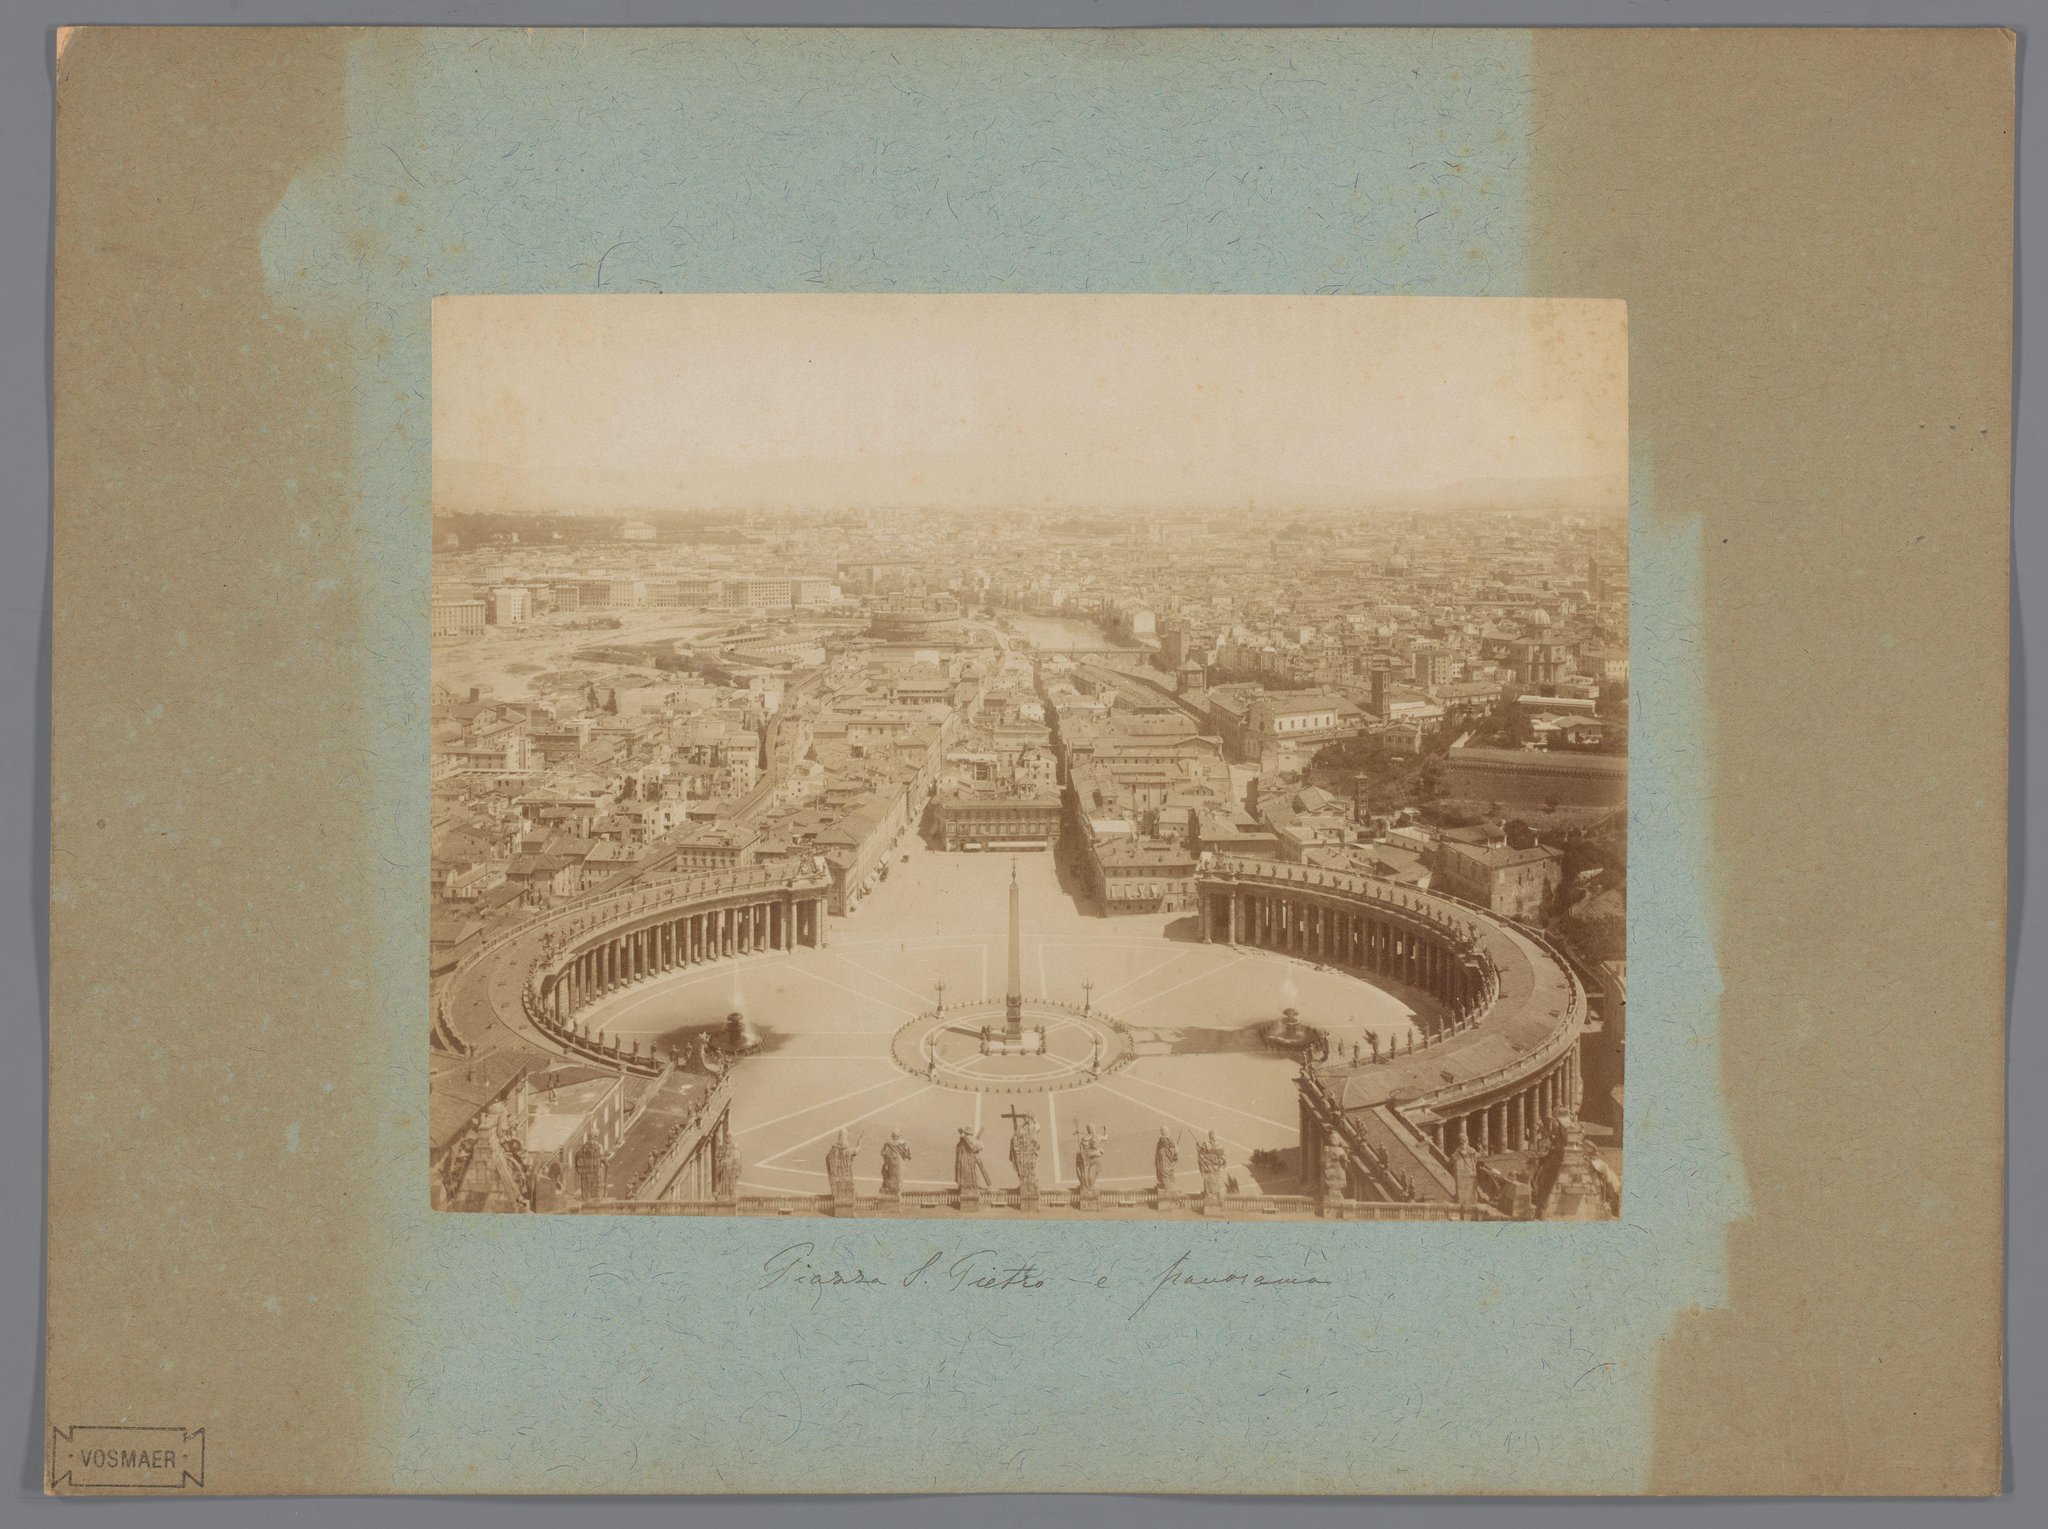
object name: photograph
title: Gezicht op het Sint-Pietersplein vanaf de Sint-Pietersbasiliek te Vaticaanstad, Italië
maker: Anonymous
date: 1851-1900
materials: cardboard, paper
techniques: albumen print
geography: rome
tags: square, place, circus, etc.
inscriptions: inscription: ‘Piazza S. Pietro e [...]’, collector's mark: ‘VOSMAER’